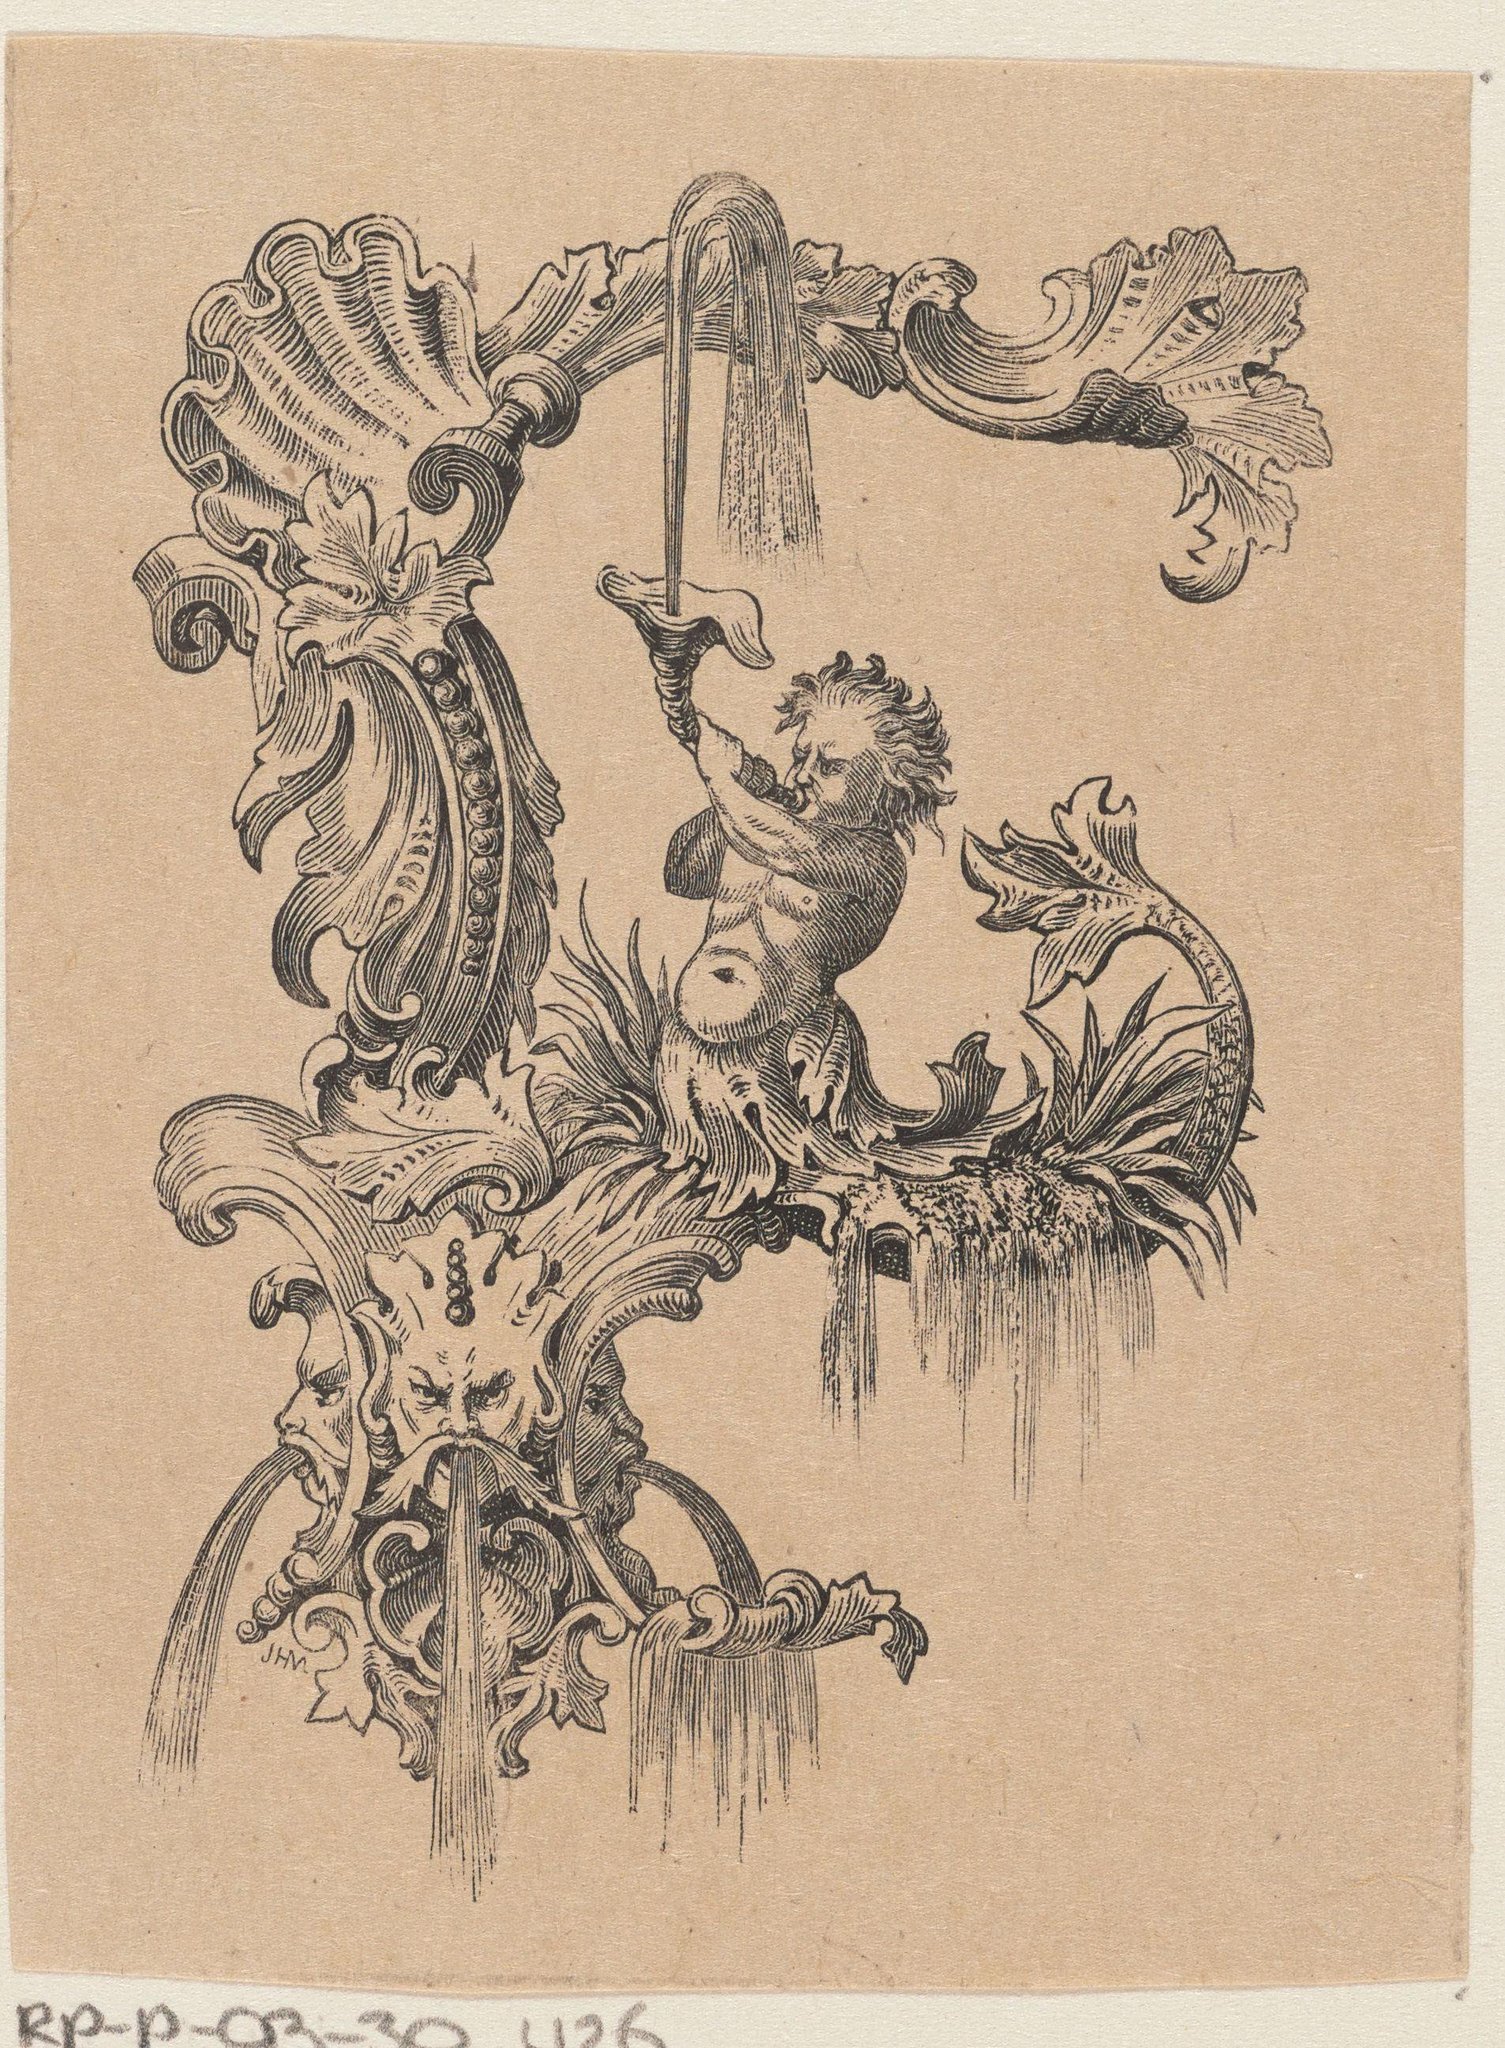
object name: print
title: Geornamenteerde letter F met een allegorische figuur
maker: isaac weissenbruch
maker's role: print maker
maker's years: 1826-1912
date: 1836-1912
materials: paper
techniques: engraving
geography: netherlands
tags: fancy letters, ornament derived from objects